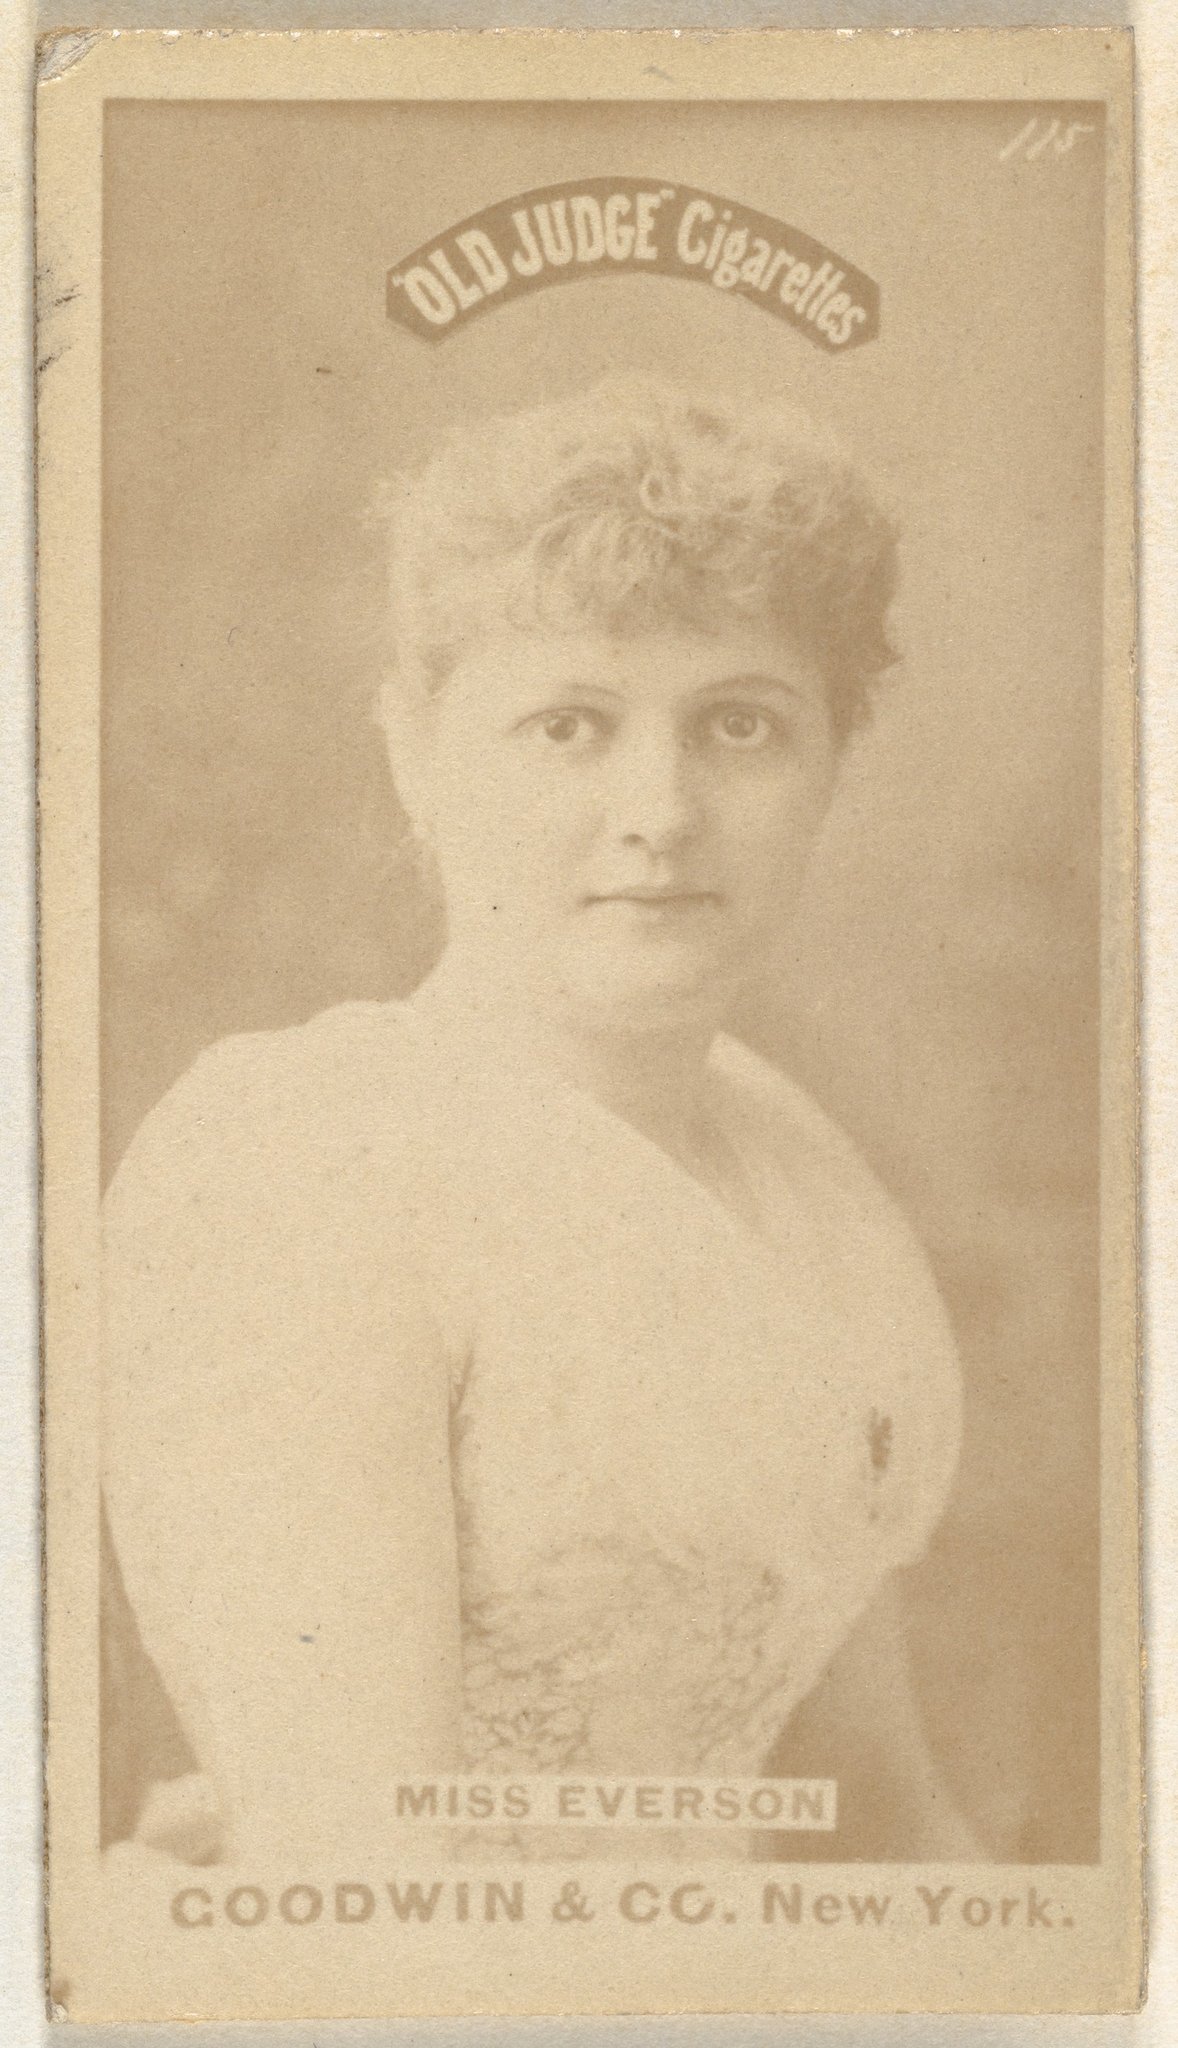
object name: photograph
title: Miss Everson, from the Actors and Actresses series (N171) for Old Judge Cigarettes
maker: goodwin & company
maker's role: publisher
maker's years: 1850-1950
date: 1886-1890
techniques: albumen silver print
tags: portraits,women,actresses